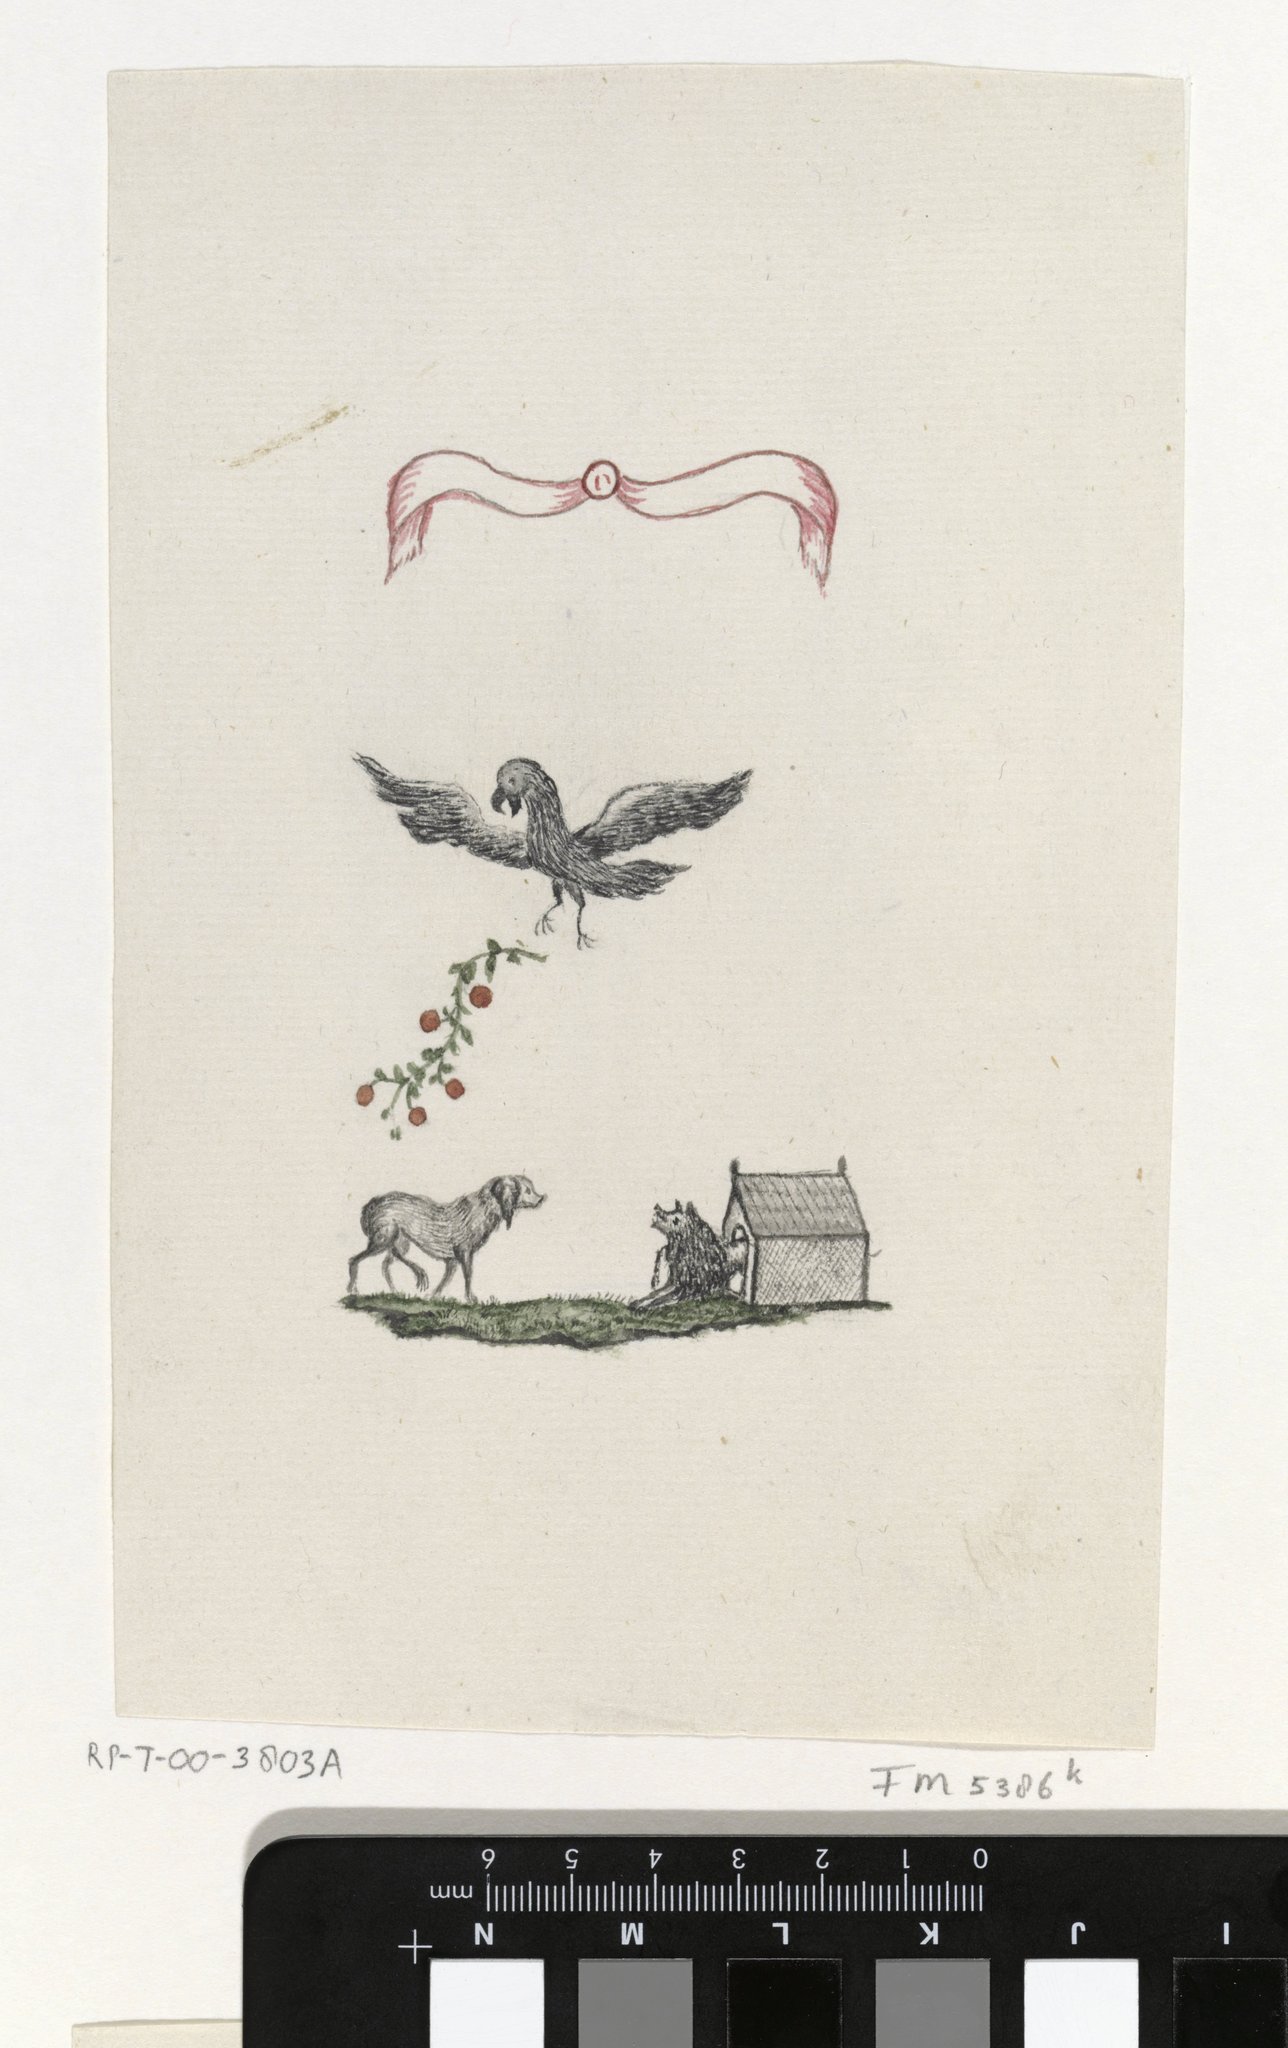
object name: drawing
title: Vignet met keeshond en roze strik, 1795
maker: Anonymous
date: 1795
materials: paint, paper, pencil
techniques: brush, pen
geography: netherlands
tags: dog, alliance with france (1795)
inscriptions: collector's mark: Lugt 2228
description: Vignet waarin een hond naar de keeshond in zijn hok toeloopt. Bovenaan onder een roze strik laat een adelaar een bloemenguirlande vallen. Onderdeel van een groep van zes getekende vignetten, mogelijk voor chasinetten bij een feest ter gelegenheid van de alliantie met Frankrijk in 1795.